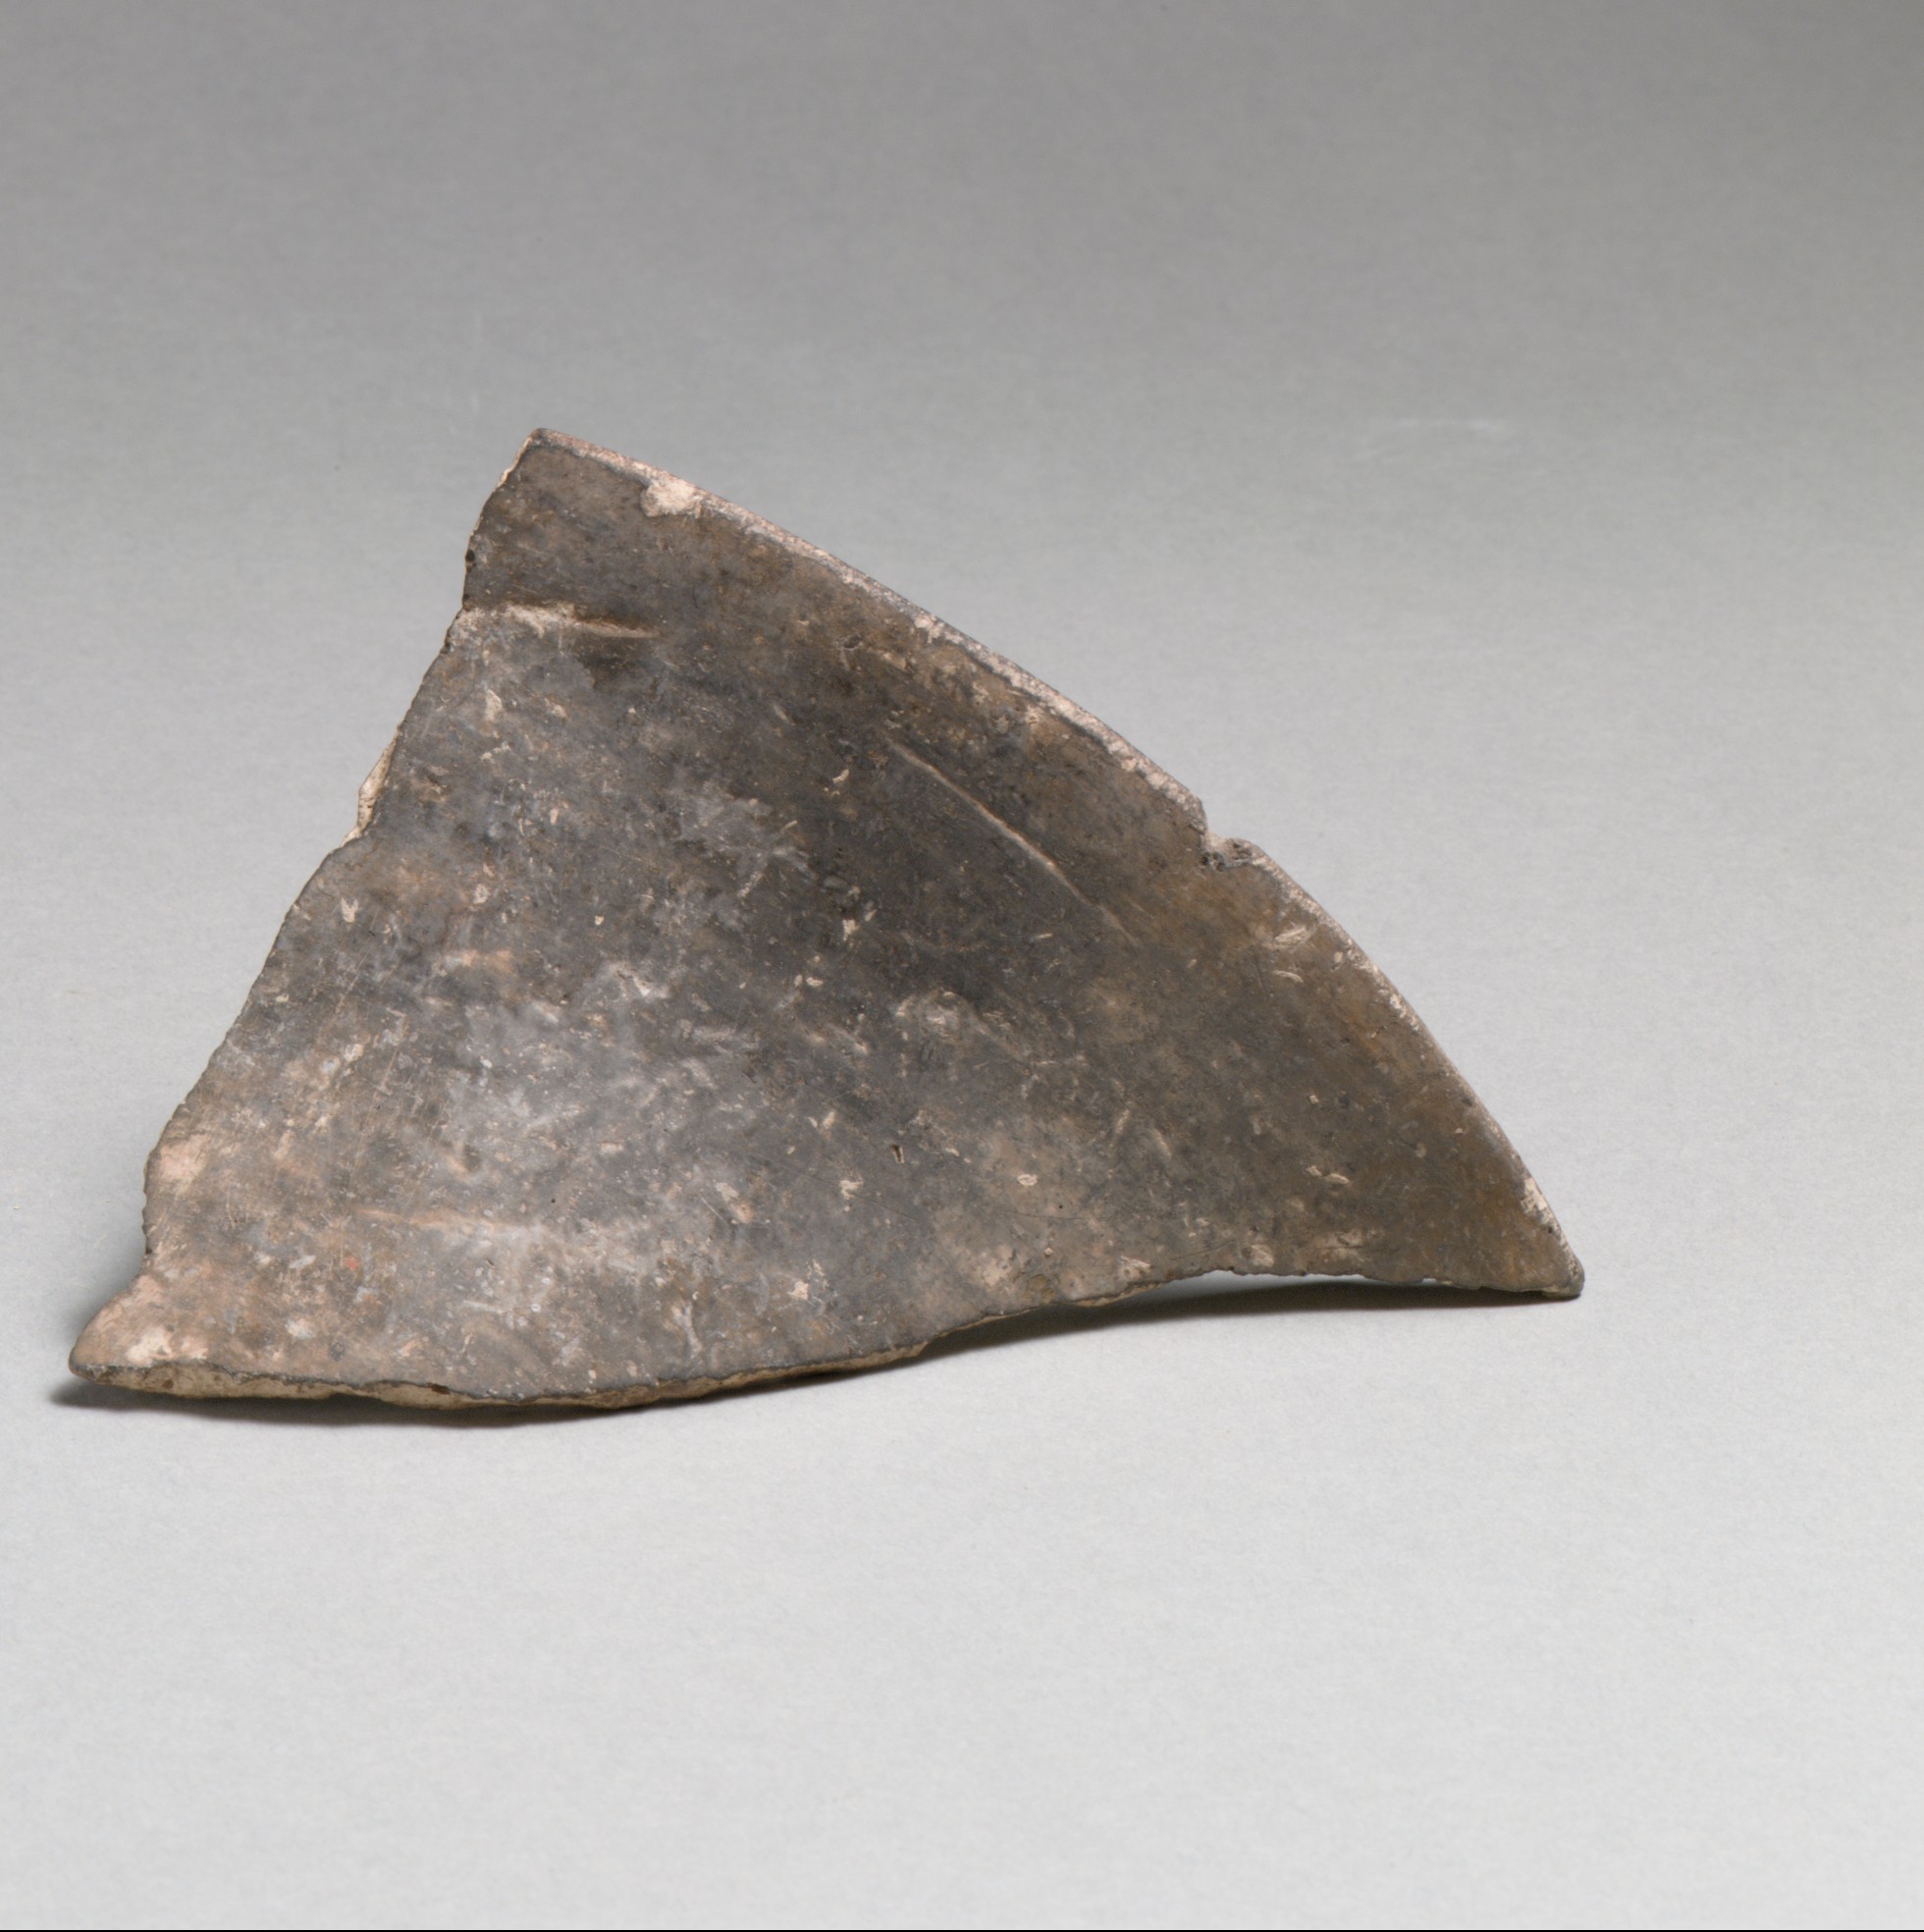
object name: vase fragment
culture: minoan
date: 2600-2000 BCE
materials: terracotta